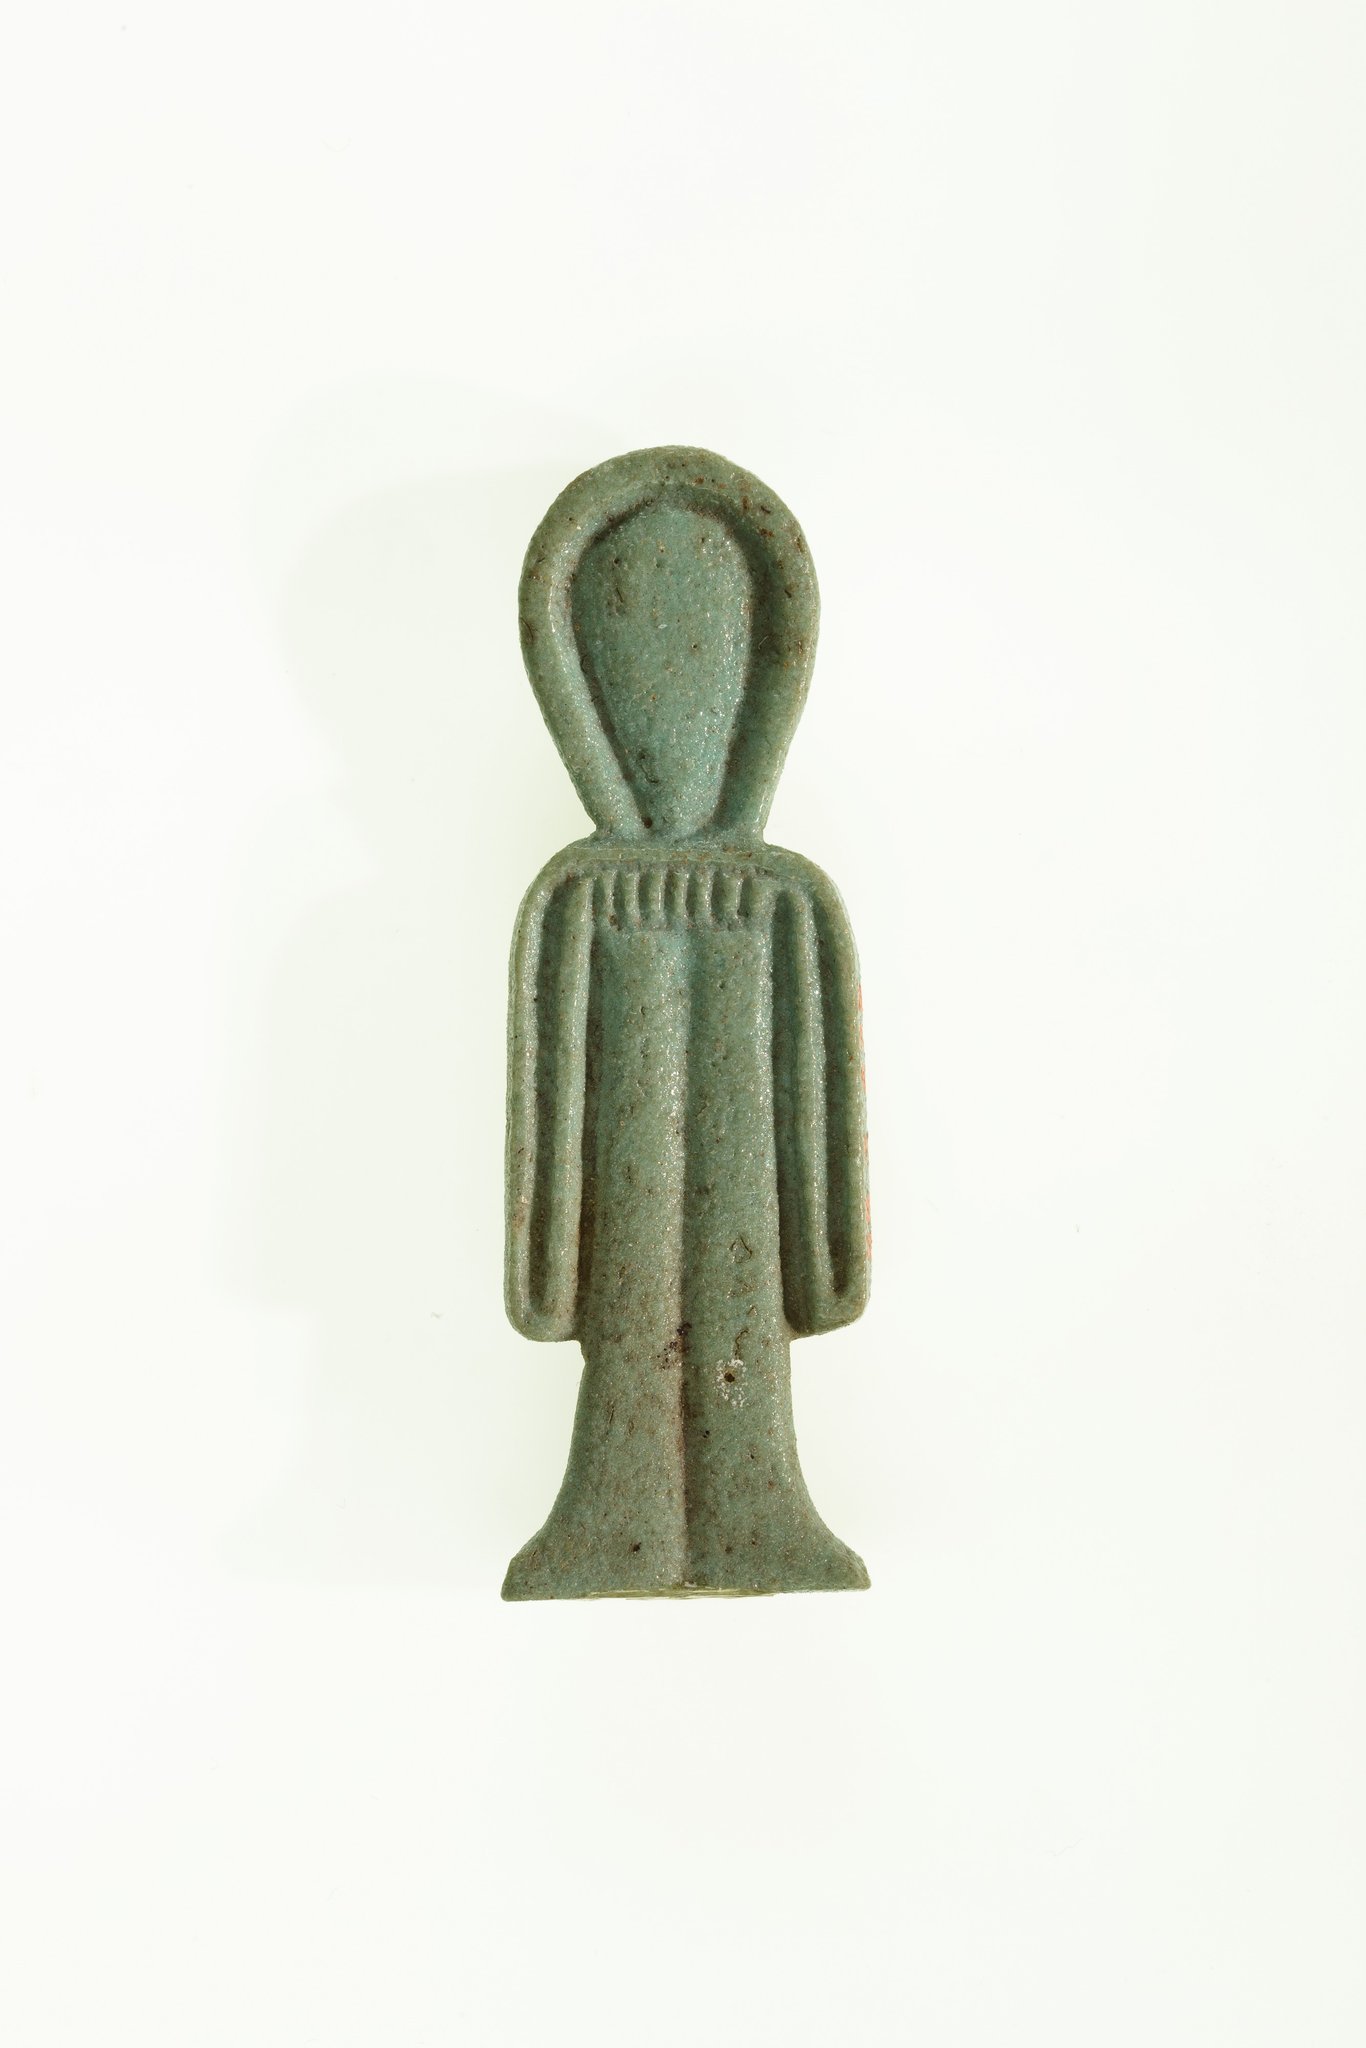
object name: amulet, tit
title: Tit (Isis knot) amulet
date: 664-332 BCE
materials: faience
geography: egypt